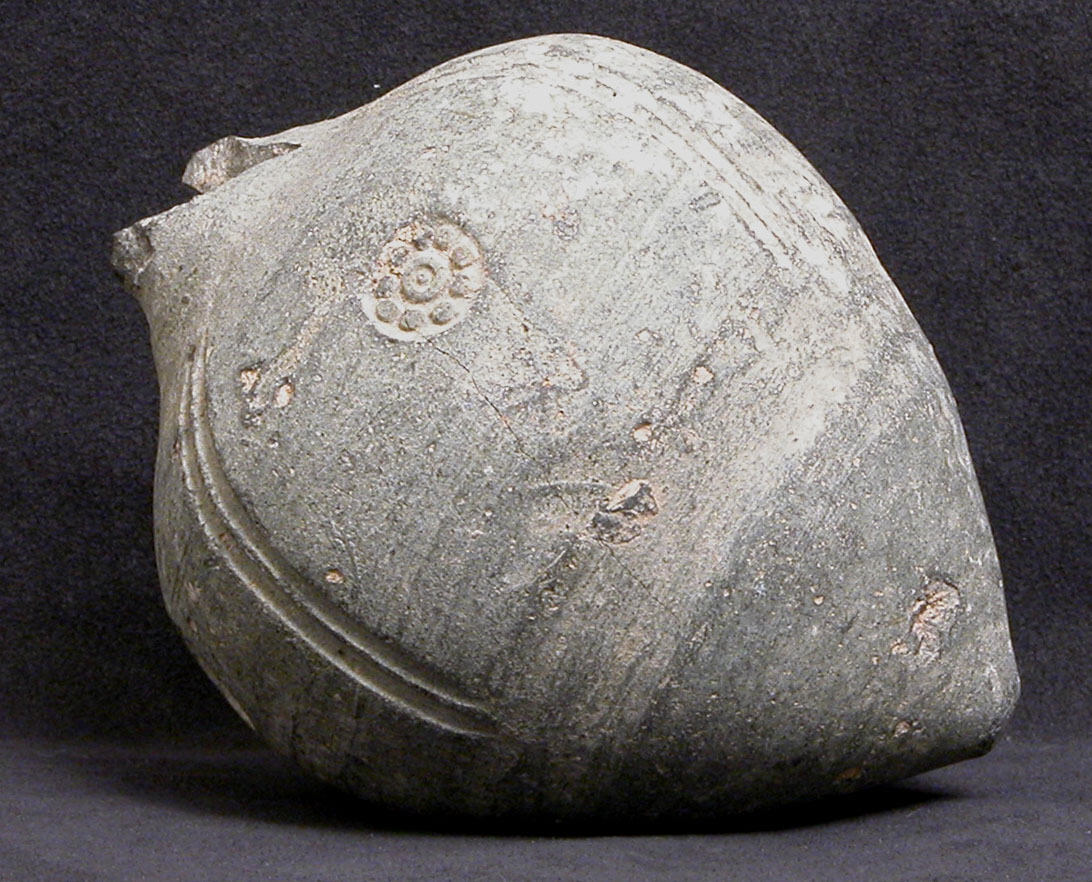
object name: vessel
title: Spheroconical Vessel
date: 801-1000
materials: earthenware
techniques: incising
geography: iran